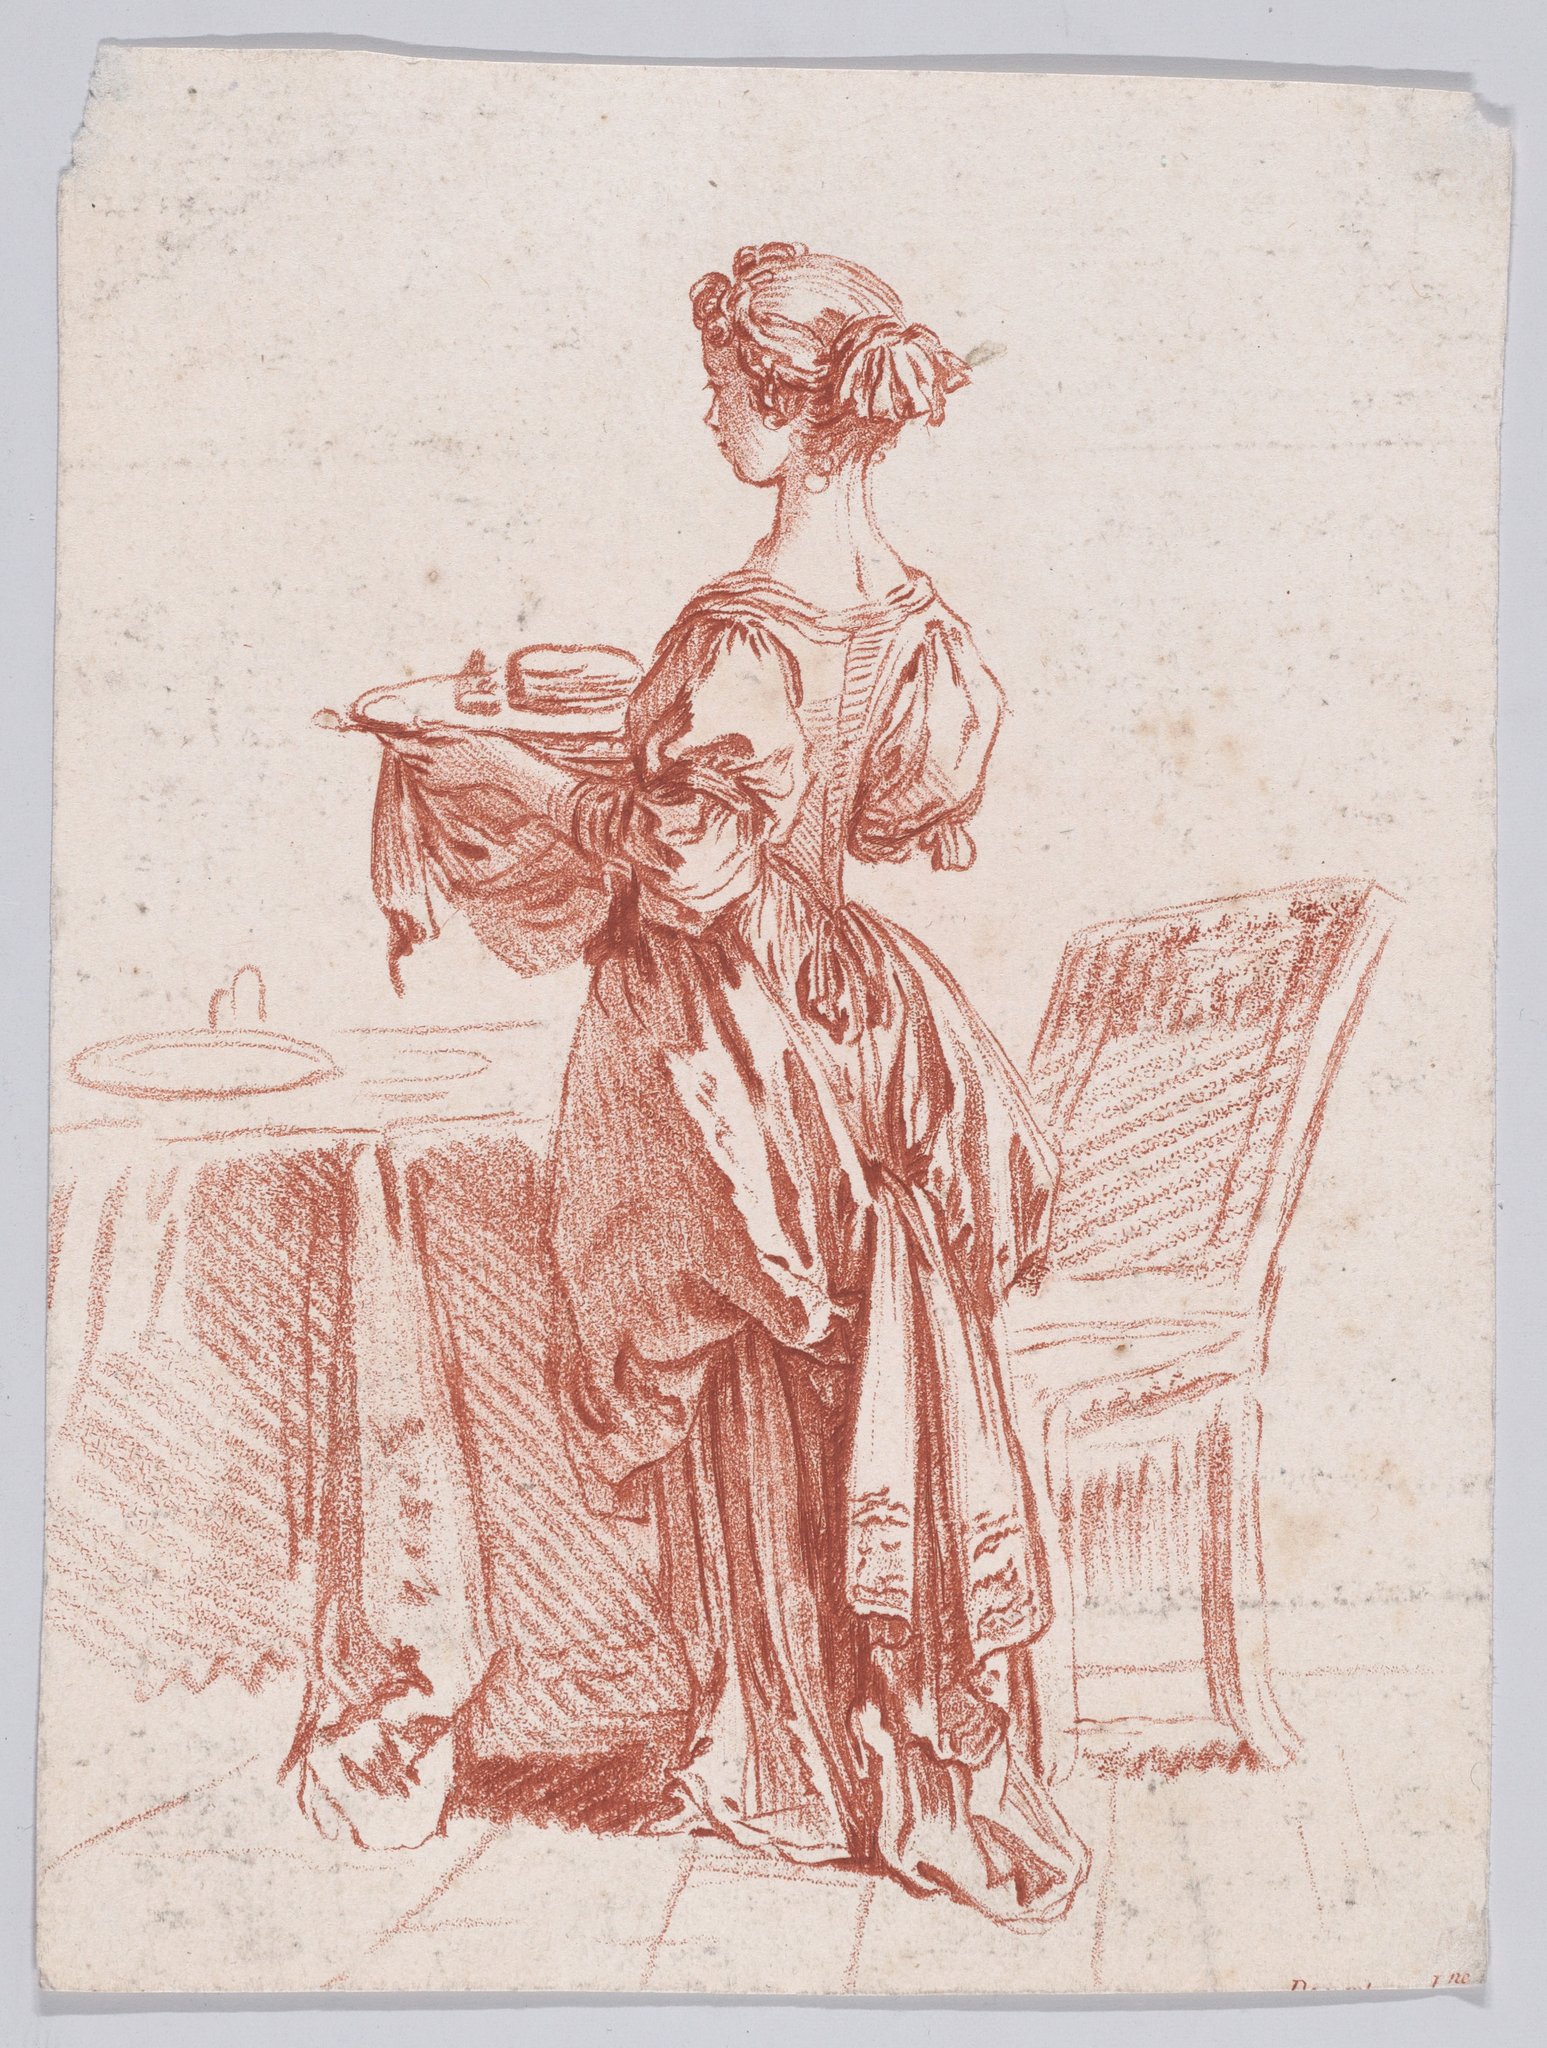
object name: print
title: Jeune femme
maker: gilles demarteau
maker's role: artist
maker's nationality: french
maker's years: 1722-1776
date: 1701-1800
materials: ink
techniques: printmaking, etching, printing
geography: france